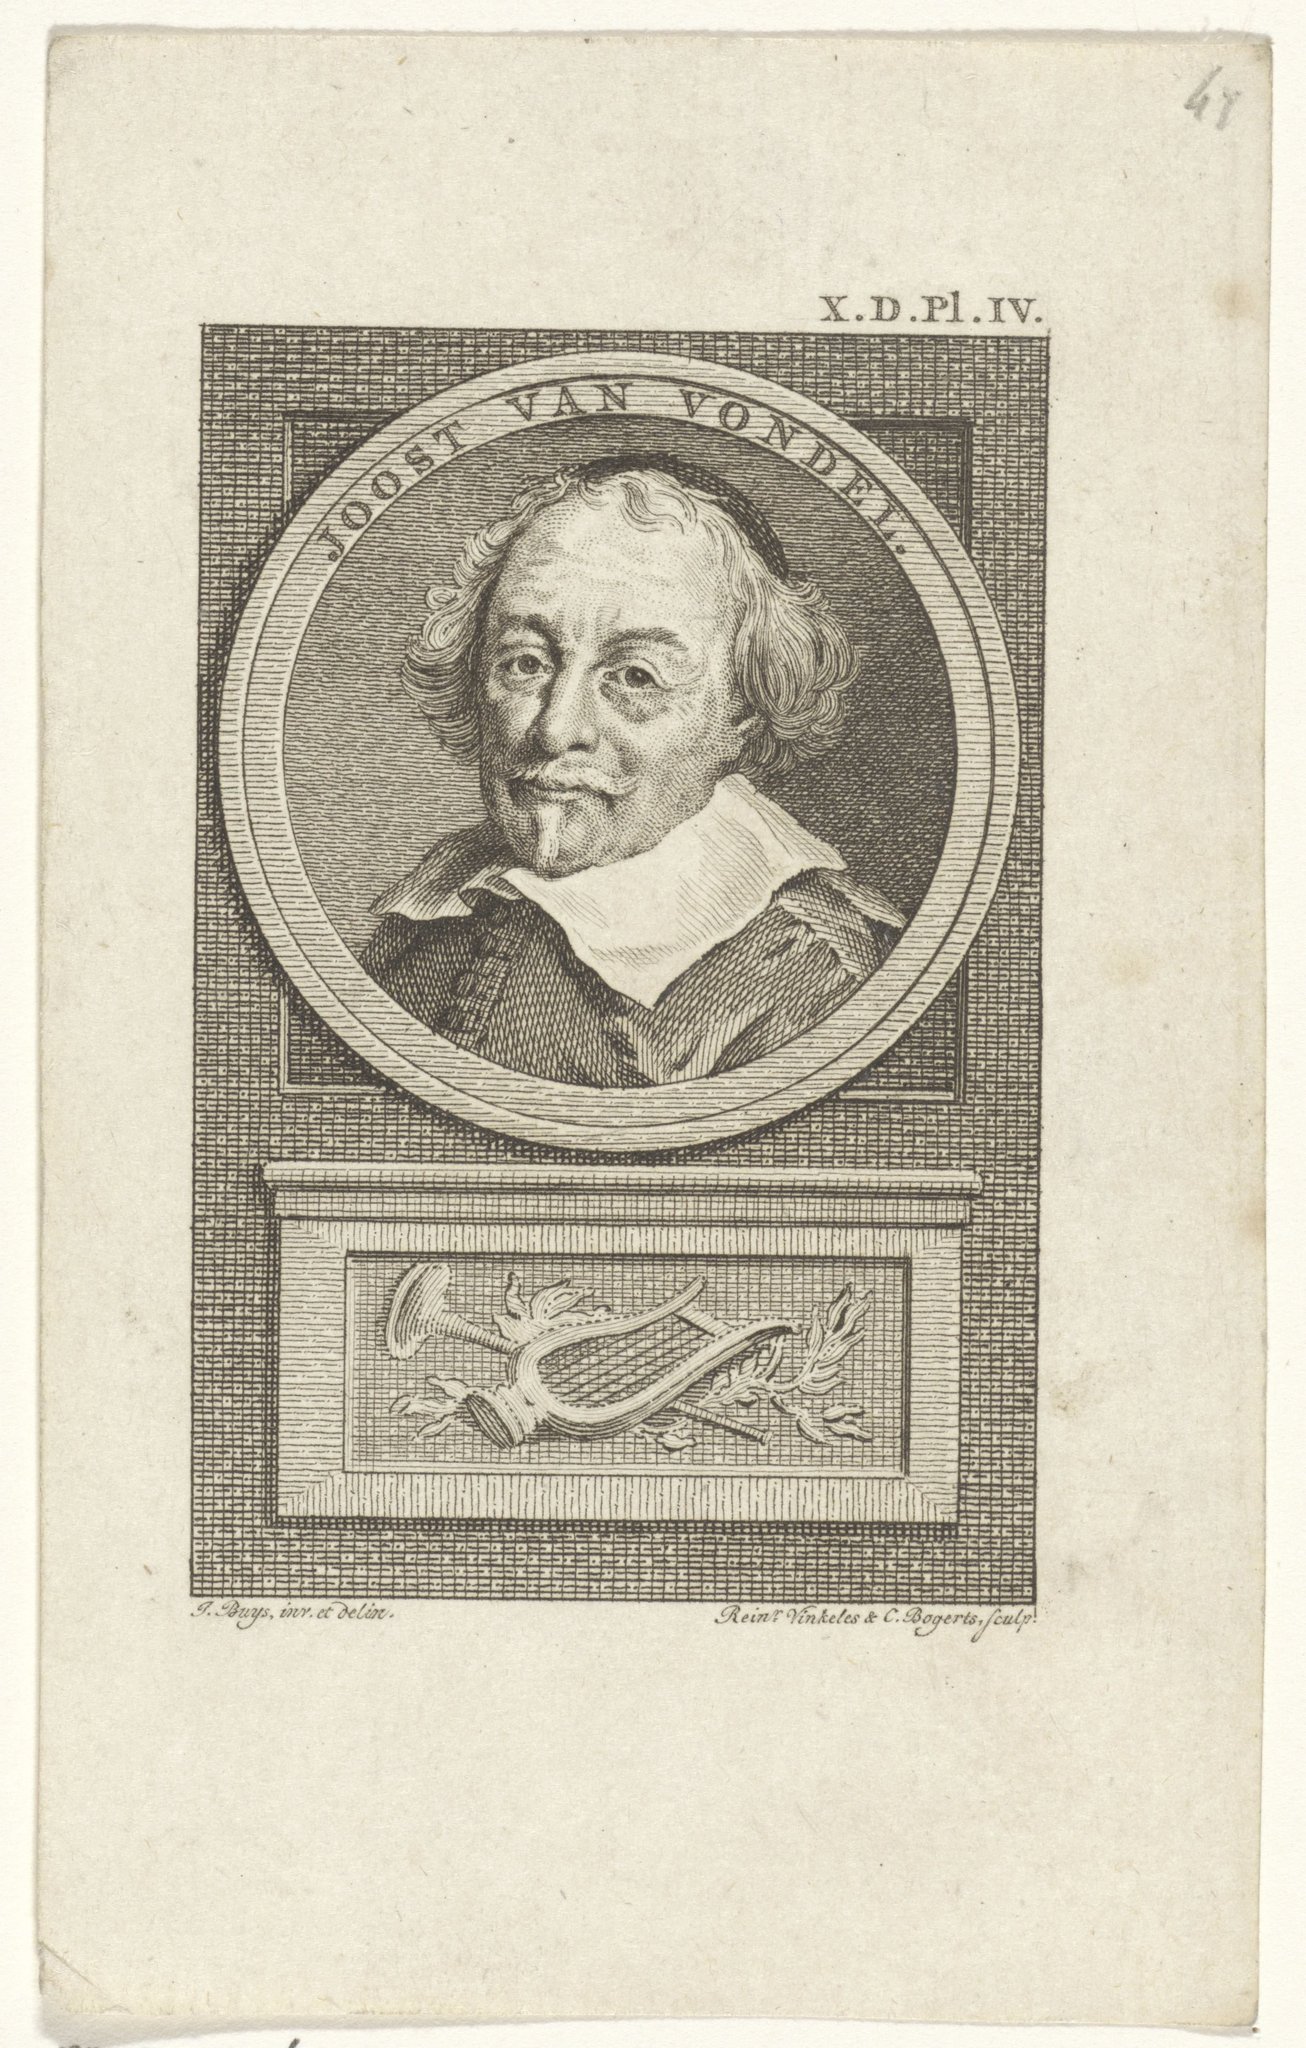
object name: book illustration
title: Portret van Joost van Vondel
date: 1783-1795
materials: paper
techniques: engraving, etching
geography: amsterdam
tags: cologne, amsterdam, joost van den vondel, lyre, cithara, psaltery, horn, trumpet, cornet, trombone, tuba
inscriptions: collector's mark: Lugt 2228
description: Prent gebruikt in: Fokke, Jan. Geschiedenissen der Vereenigde Nederlanden voor de vaderlandsche jeugd Ie-XXVste deel. Amsterdam: Johannes Allart, 1783-1795. Deel X.